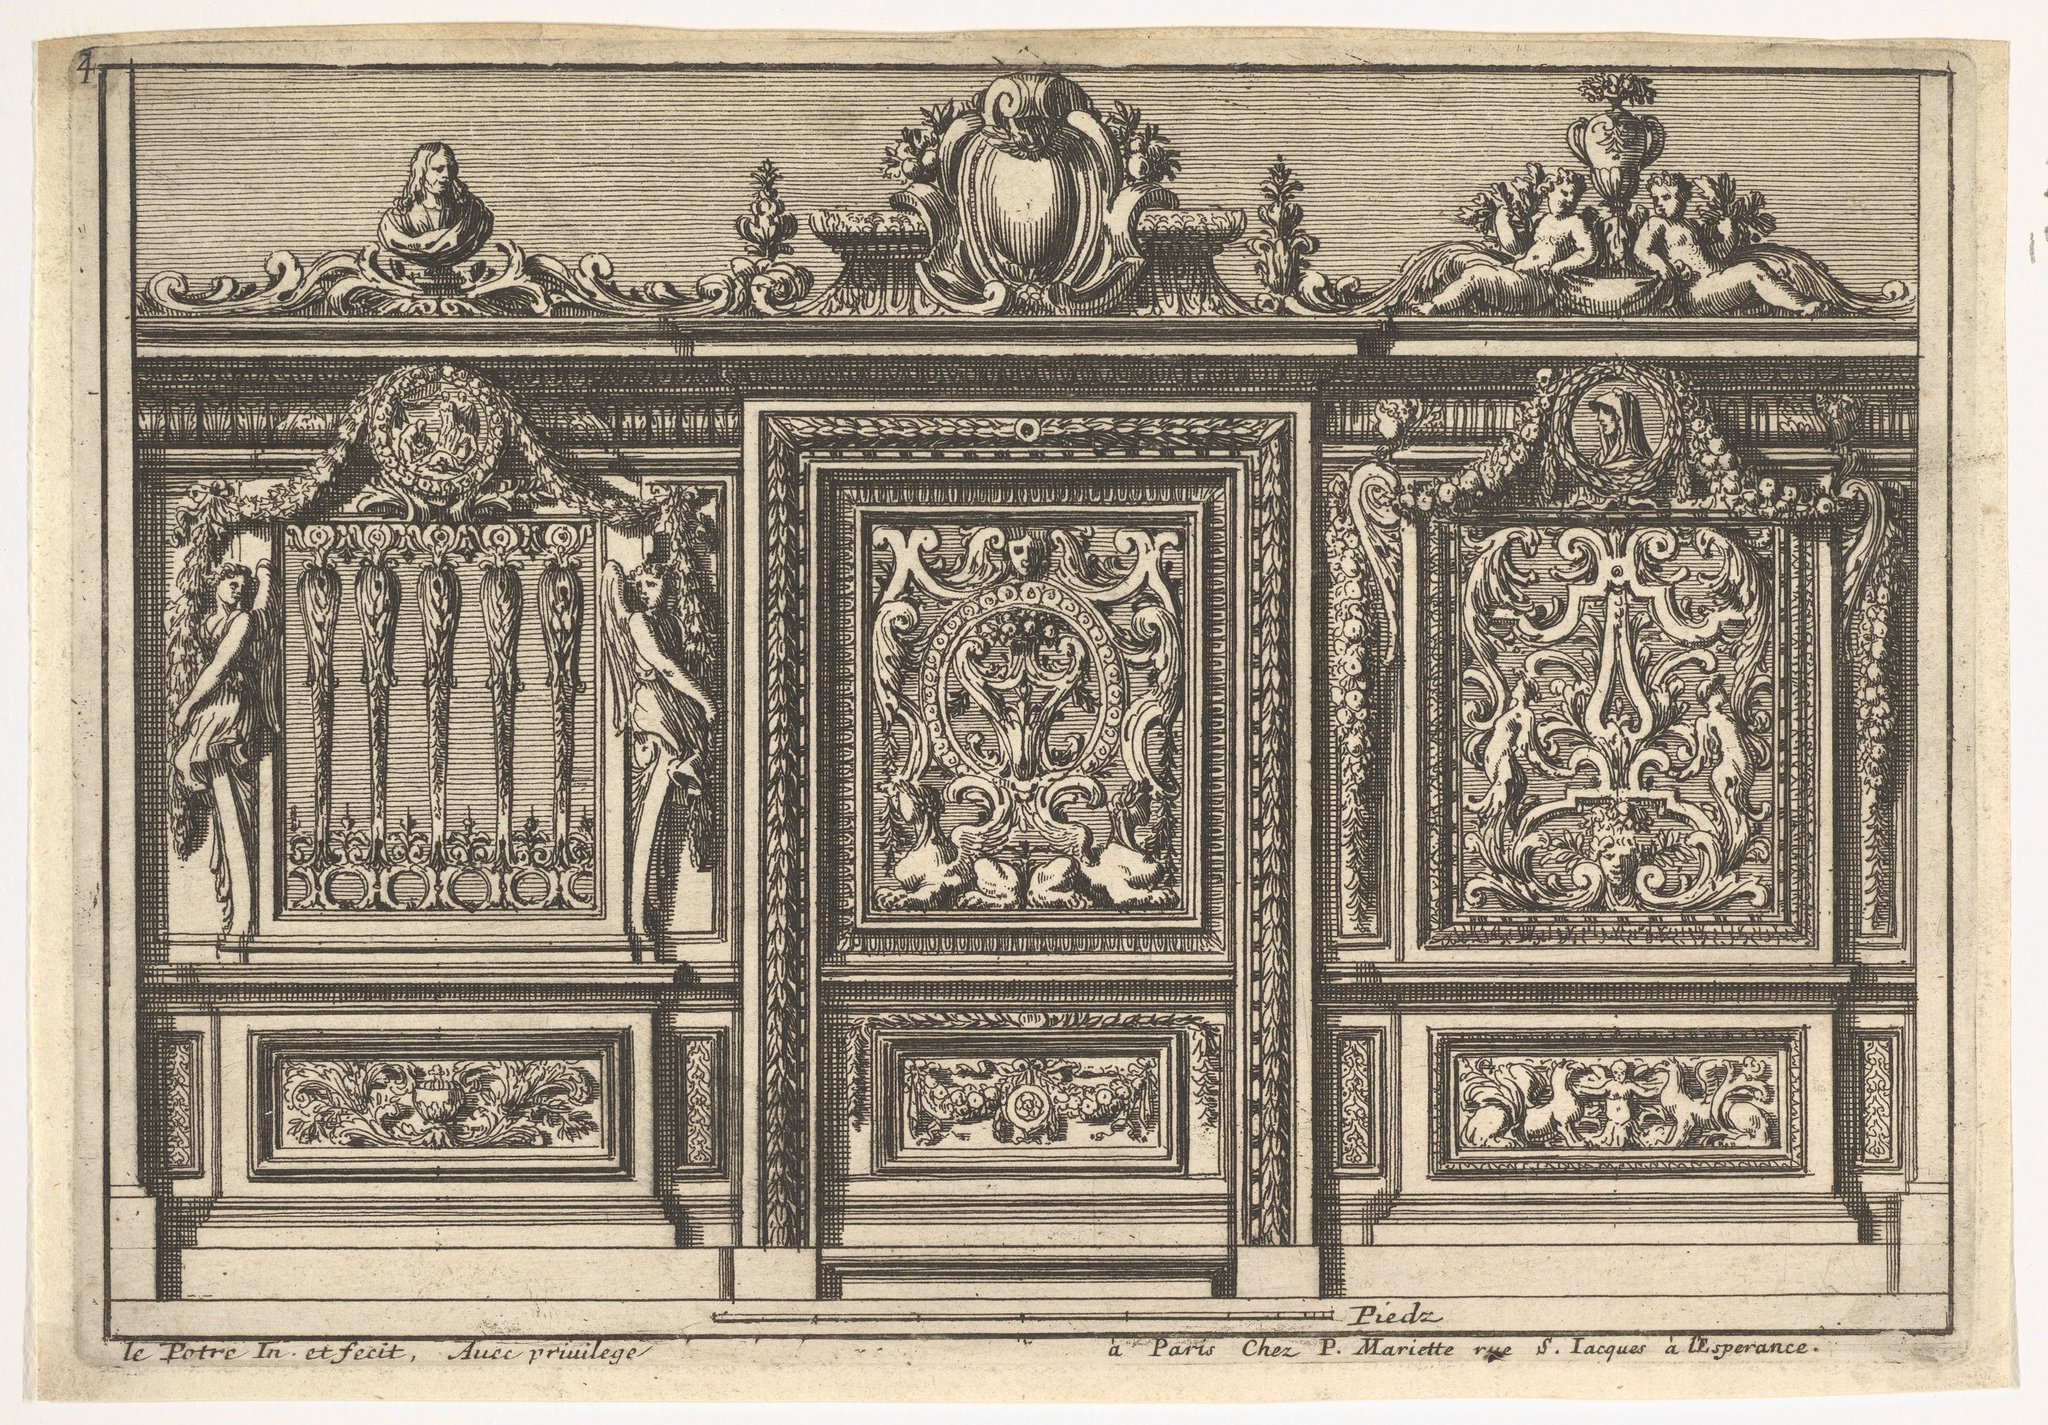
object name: print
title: Design for a Choir Screen with Two Variants, from "Clôtures de chapelles"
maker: jean le pautre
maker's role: artist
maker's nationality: french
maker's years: 1618-1682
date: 1601-1700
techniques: etching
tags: women,screens